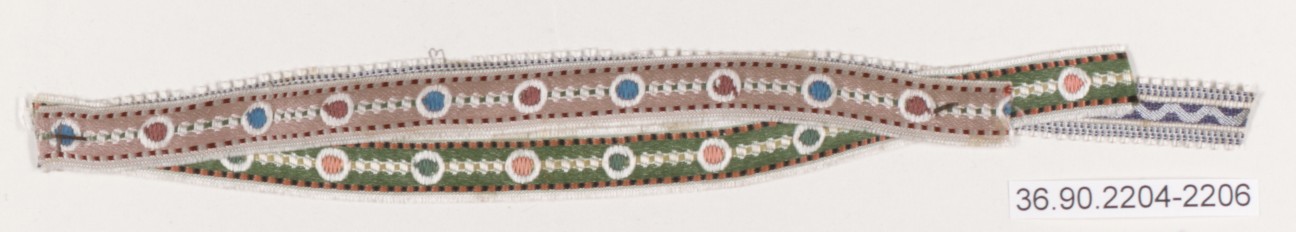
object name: piece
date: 1801-1900